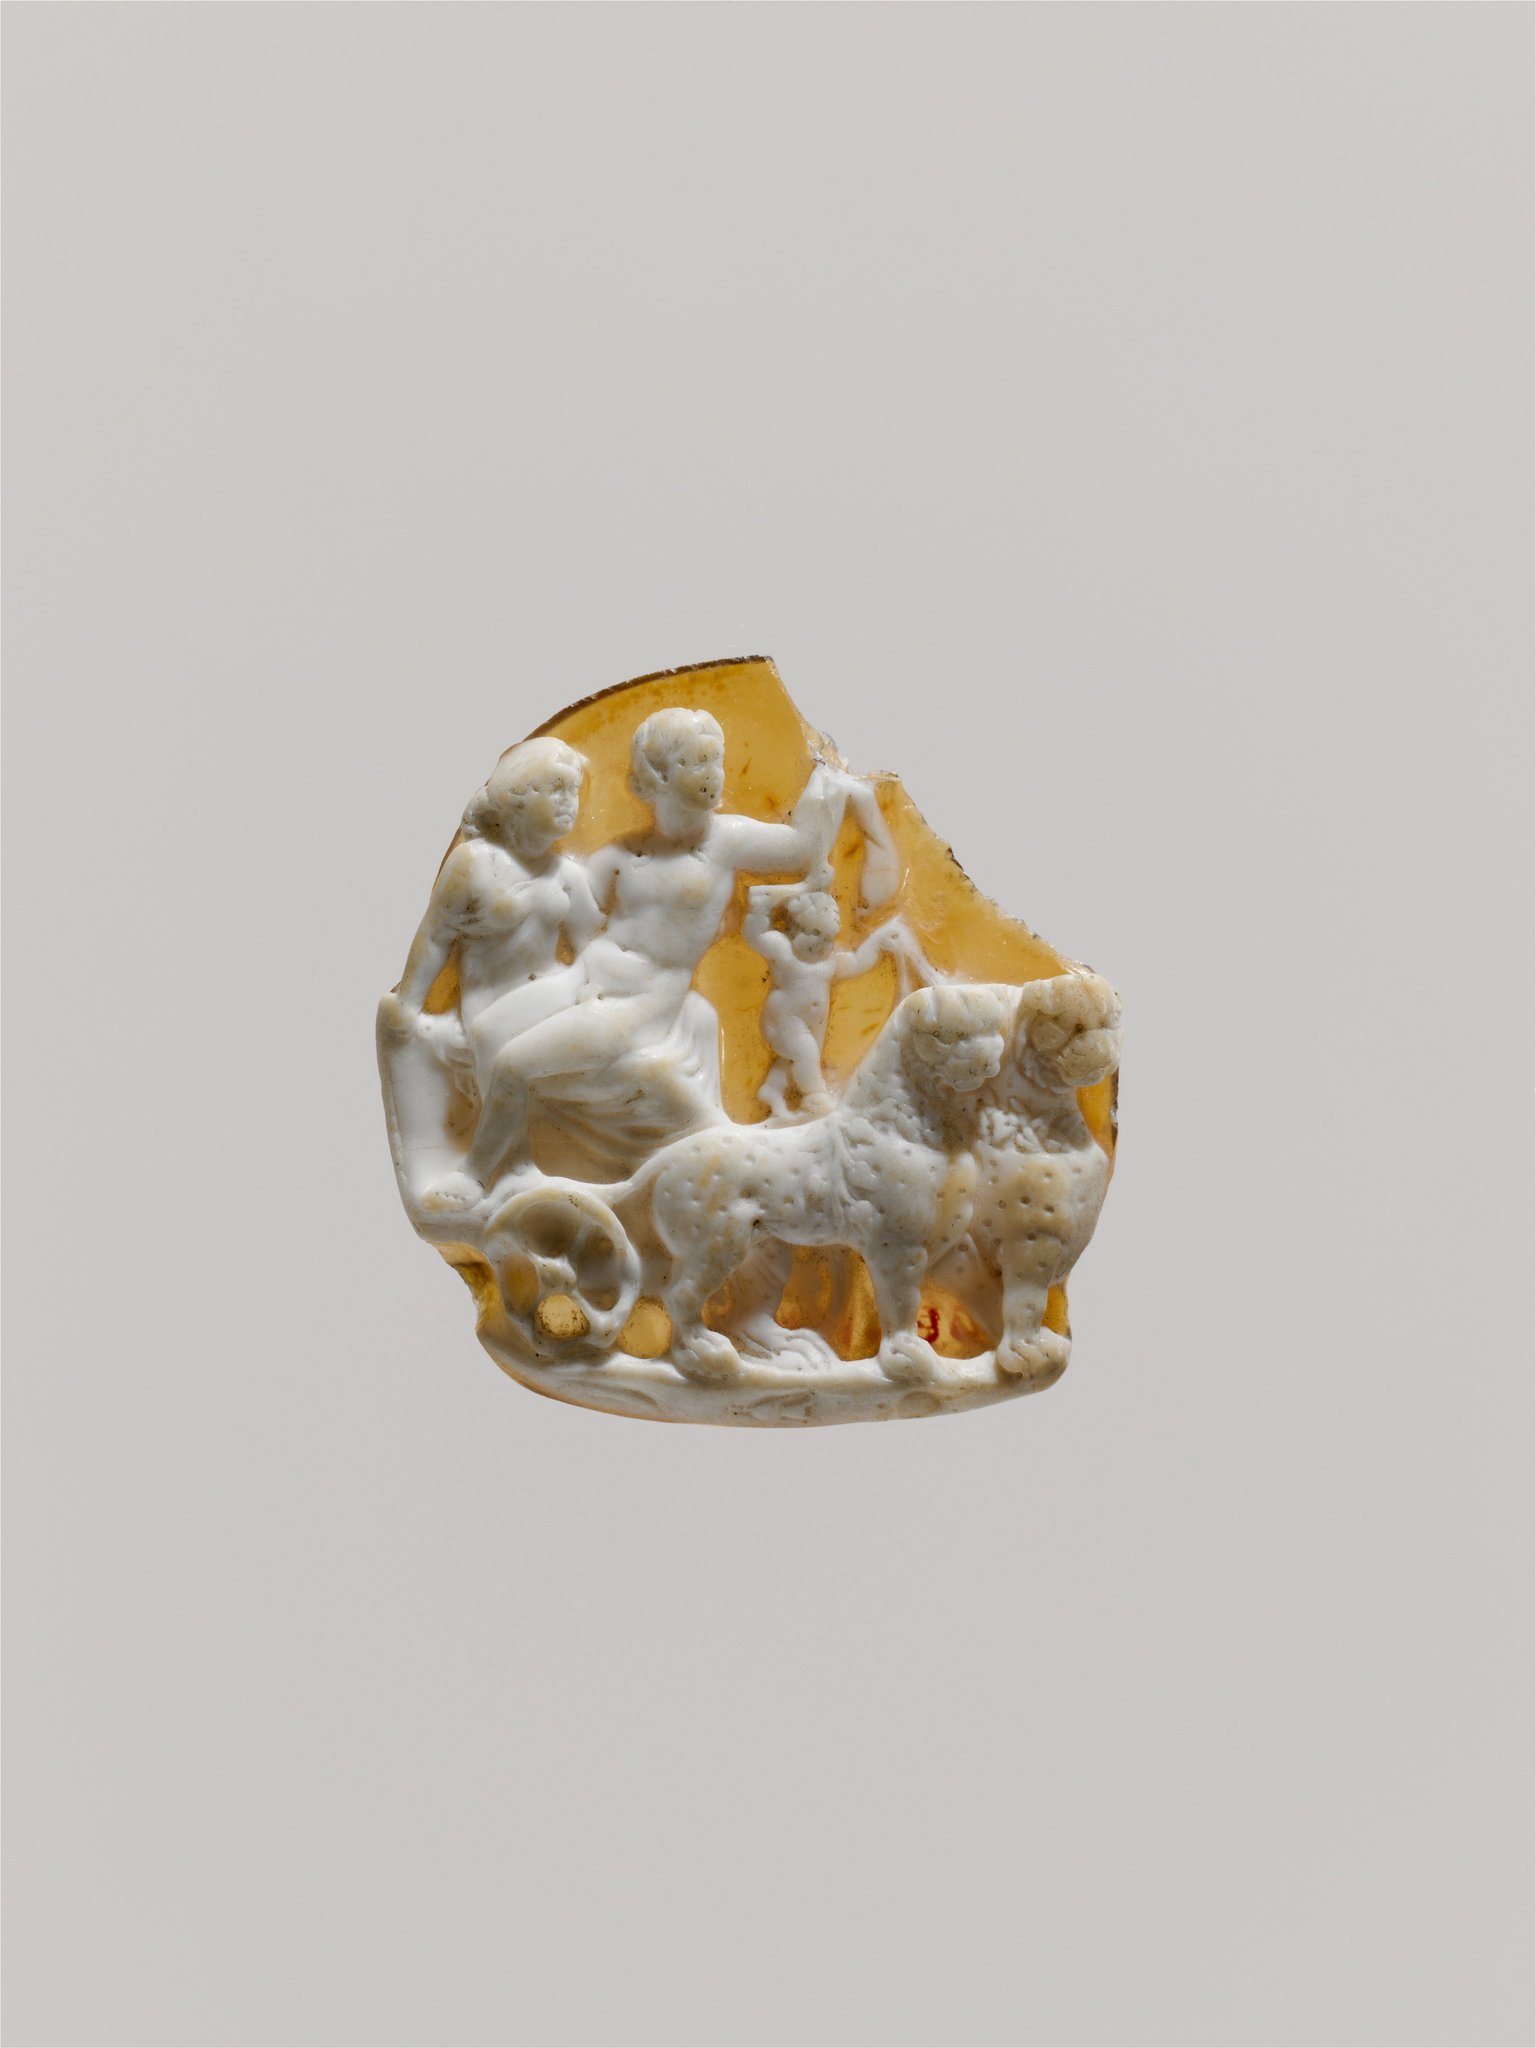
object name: cameo, sardonyx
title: Sardonyx cameo with Dionysus and Ariadne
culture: greek or roman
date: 100 BCE-100 CE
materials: gemstone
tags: animals,dionysus,ariadne,chariots